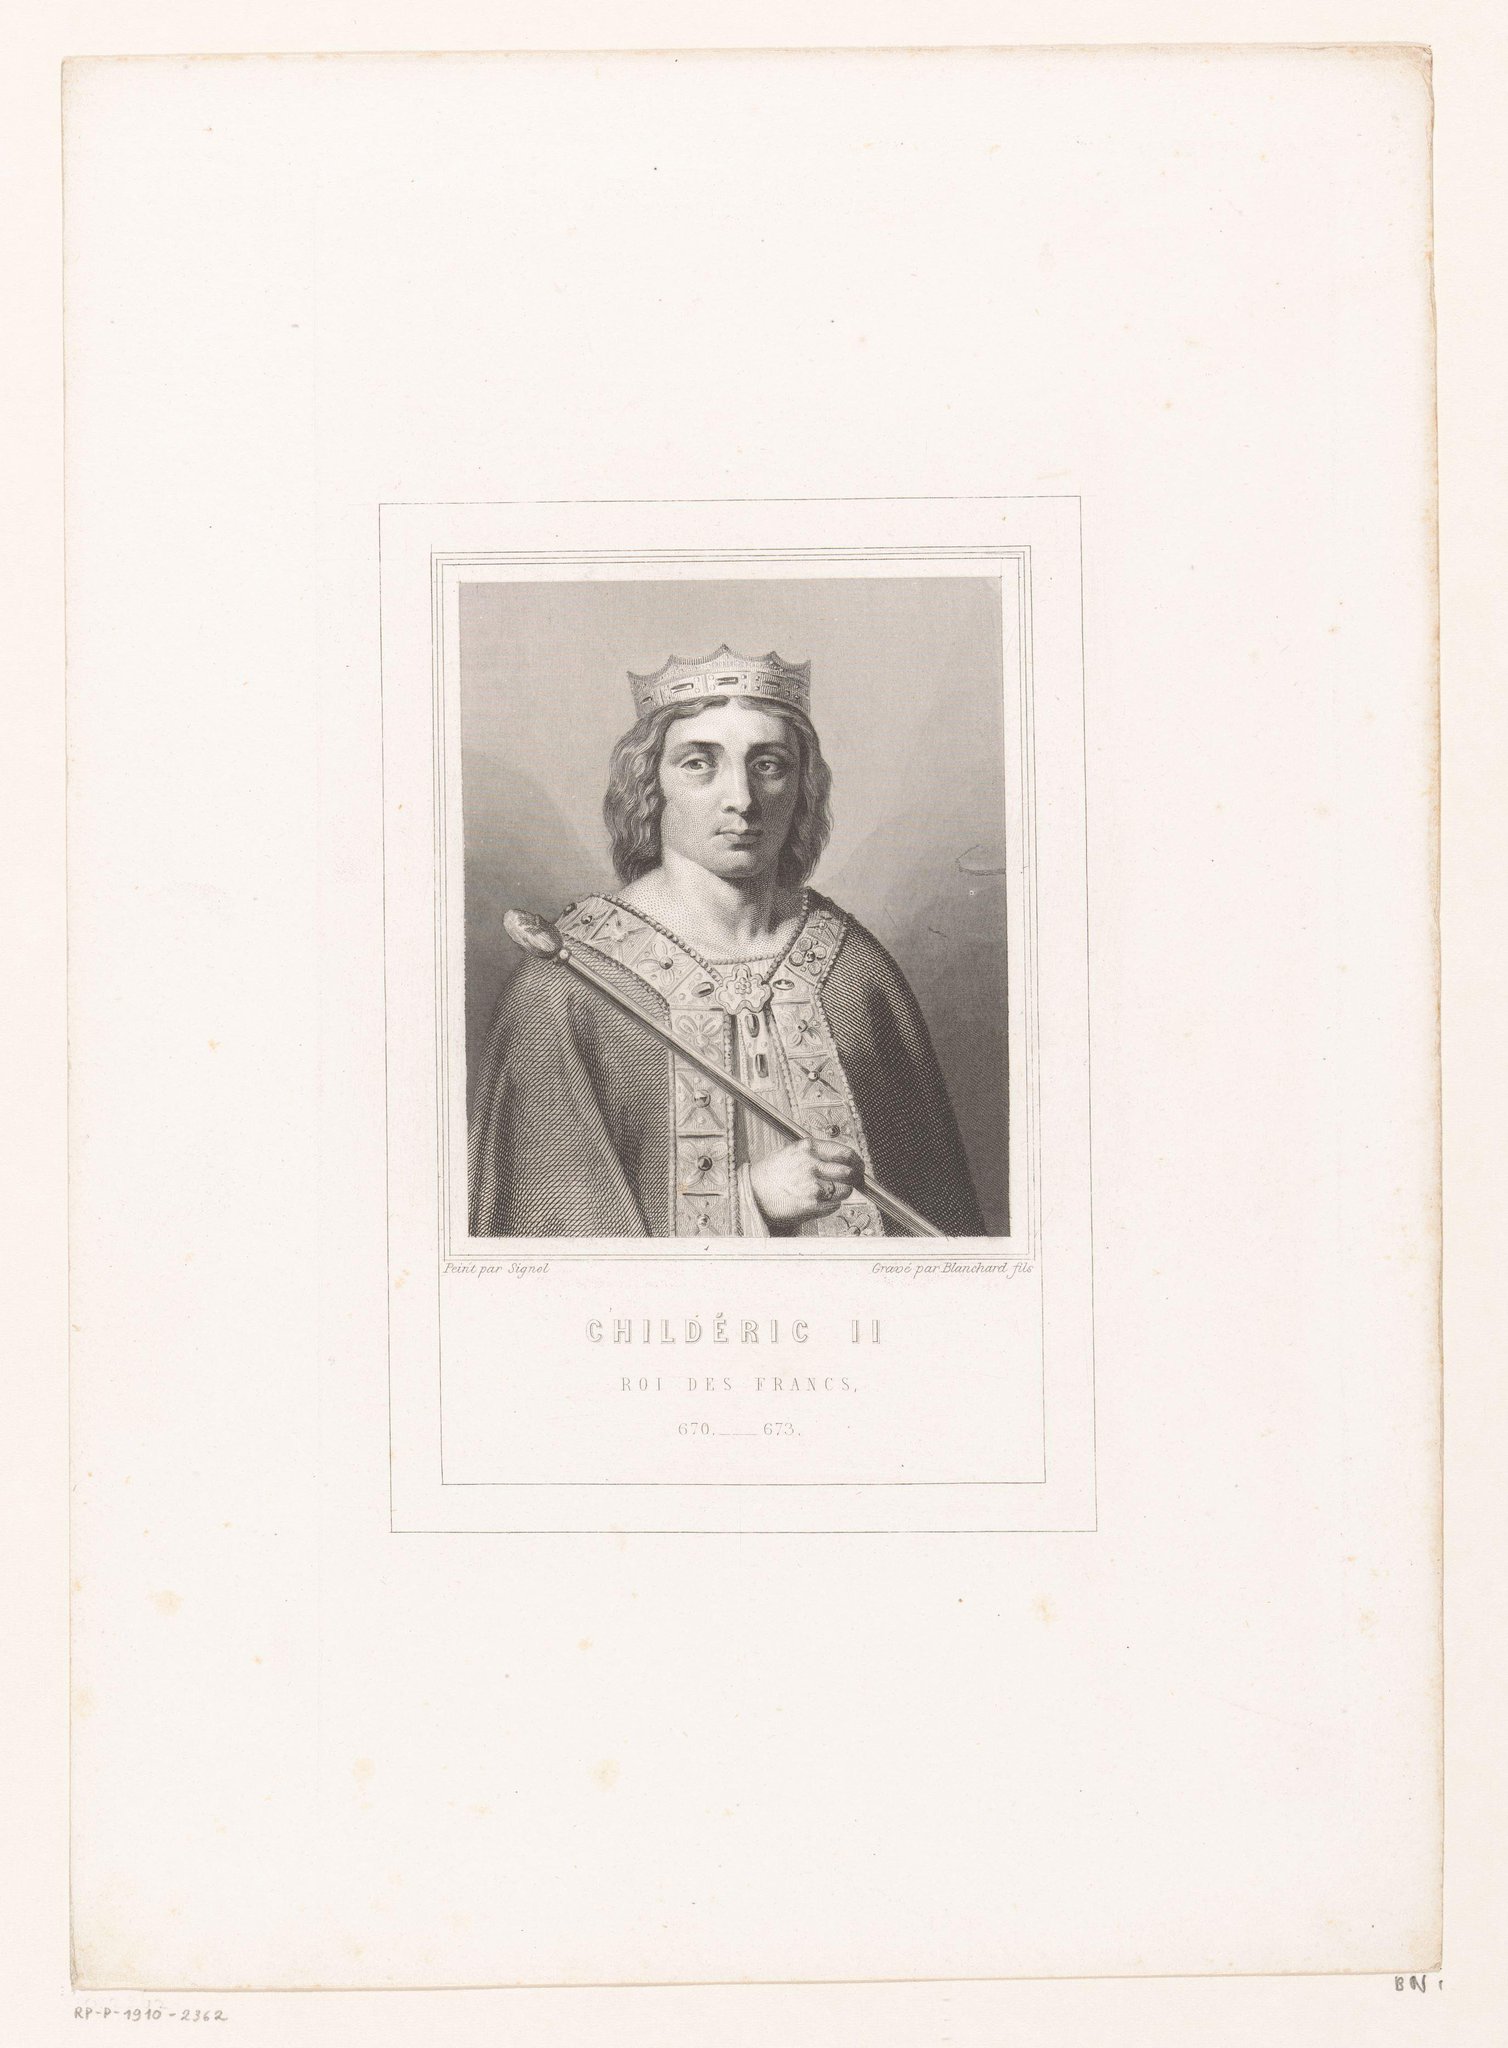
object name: print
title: Childéric II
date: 1829-1898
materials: paper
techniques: etching, engraving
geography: france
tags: historical persons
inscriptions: collector's mark: Lugt 2228